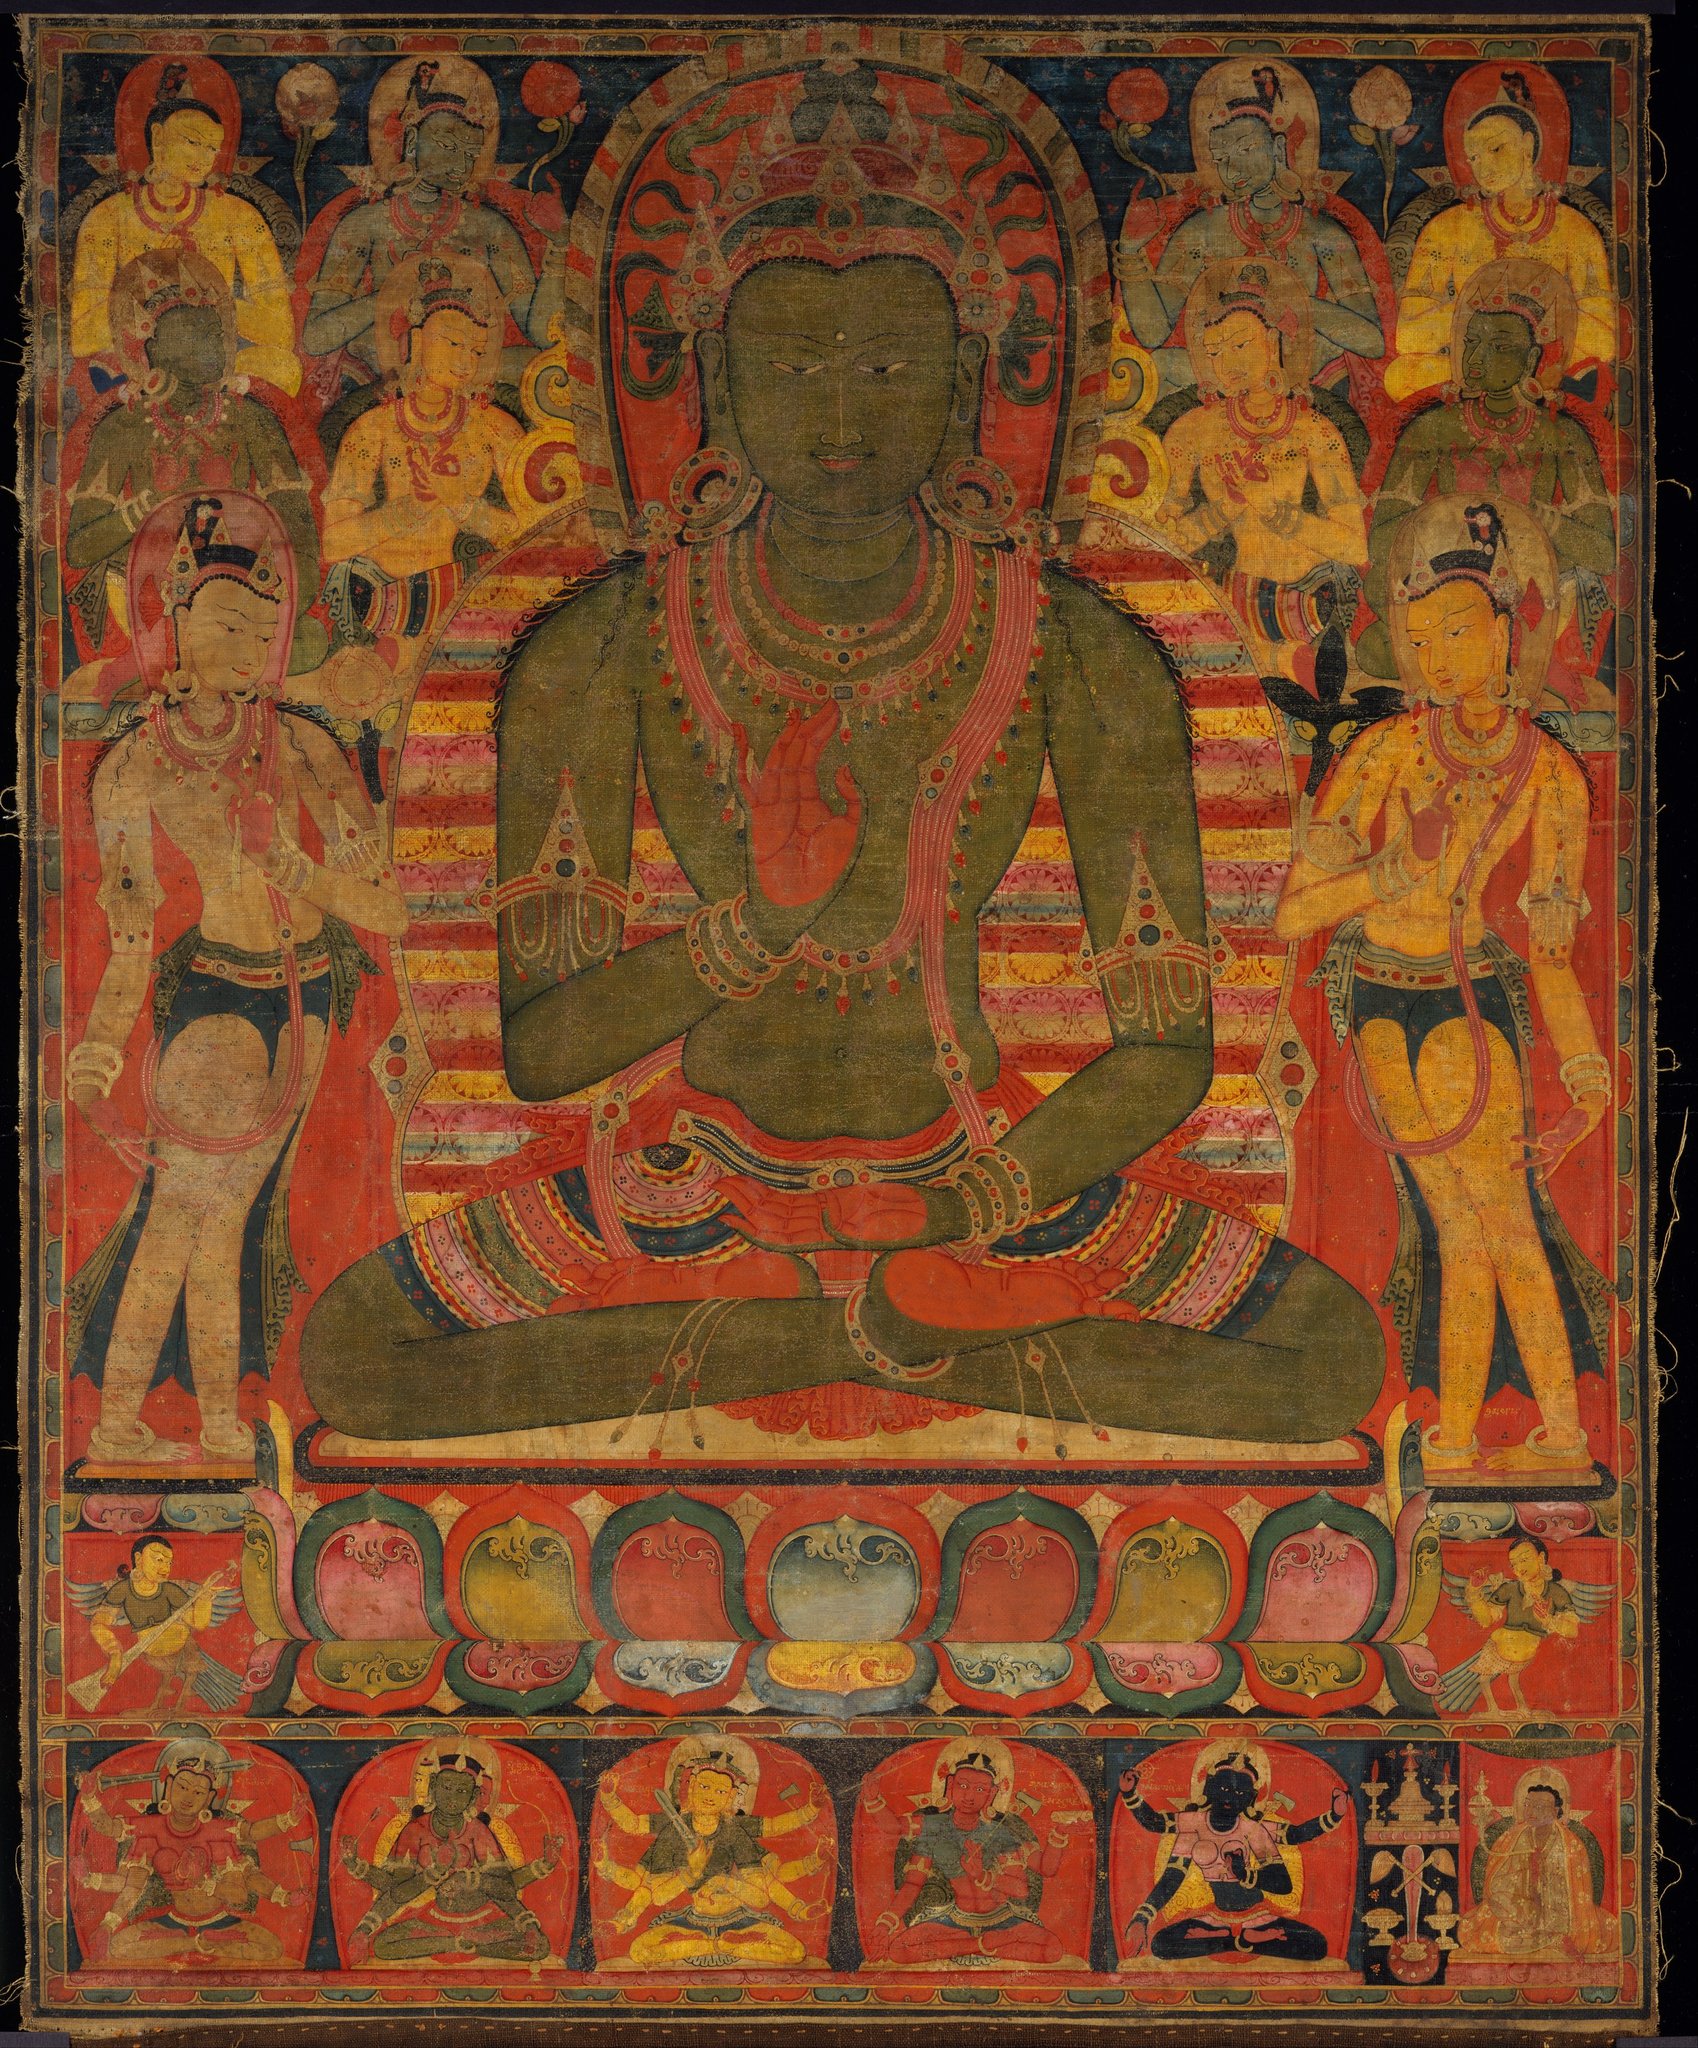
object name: thangka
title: Buddha Amoghasiddhi with Eight Bodhisattvas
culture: tibetan, central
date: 1200-1250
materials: textile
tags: buddhism,amoghasiddhi,bodhisattvas,buddha